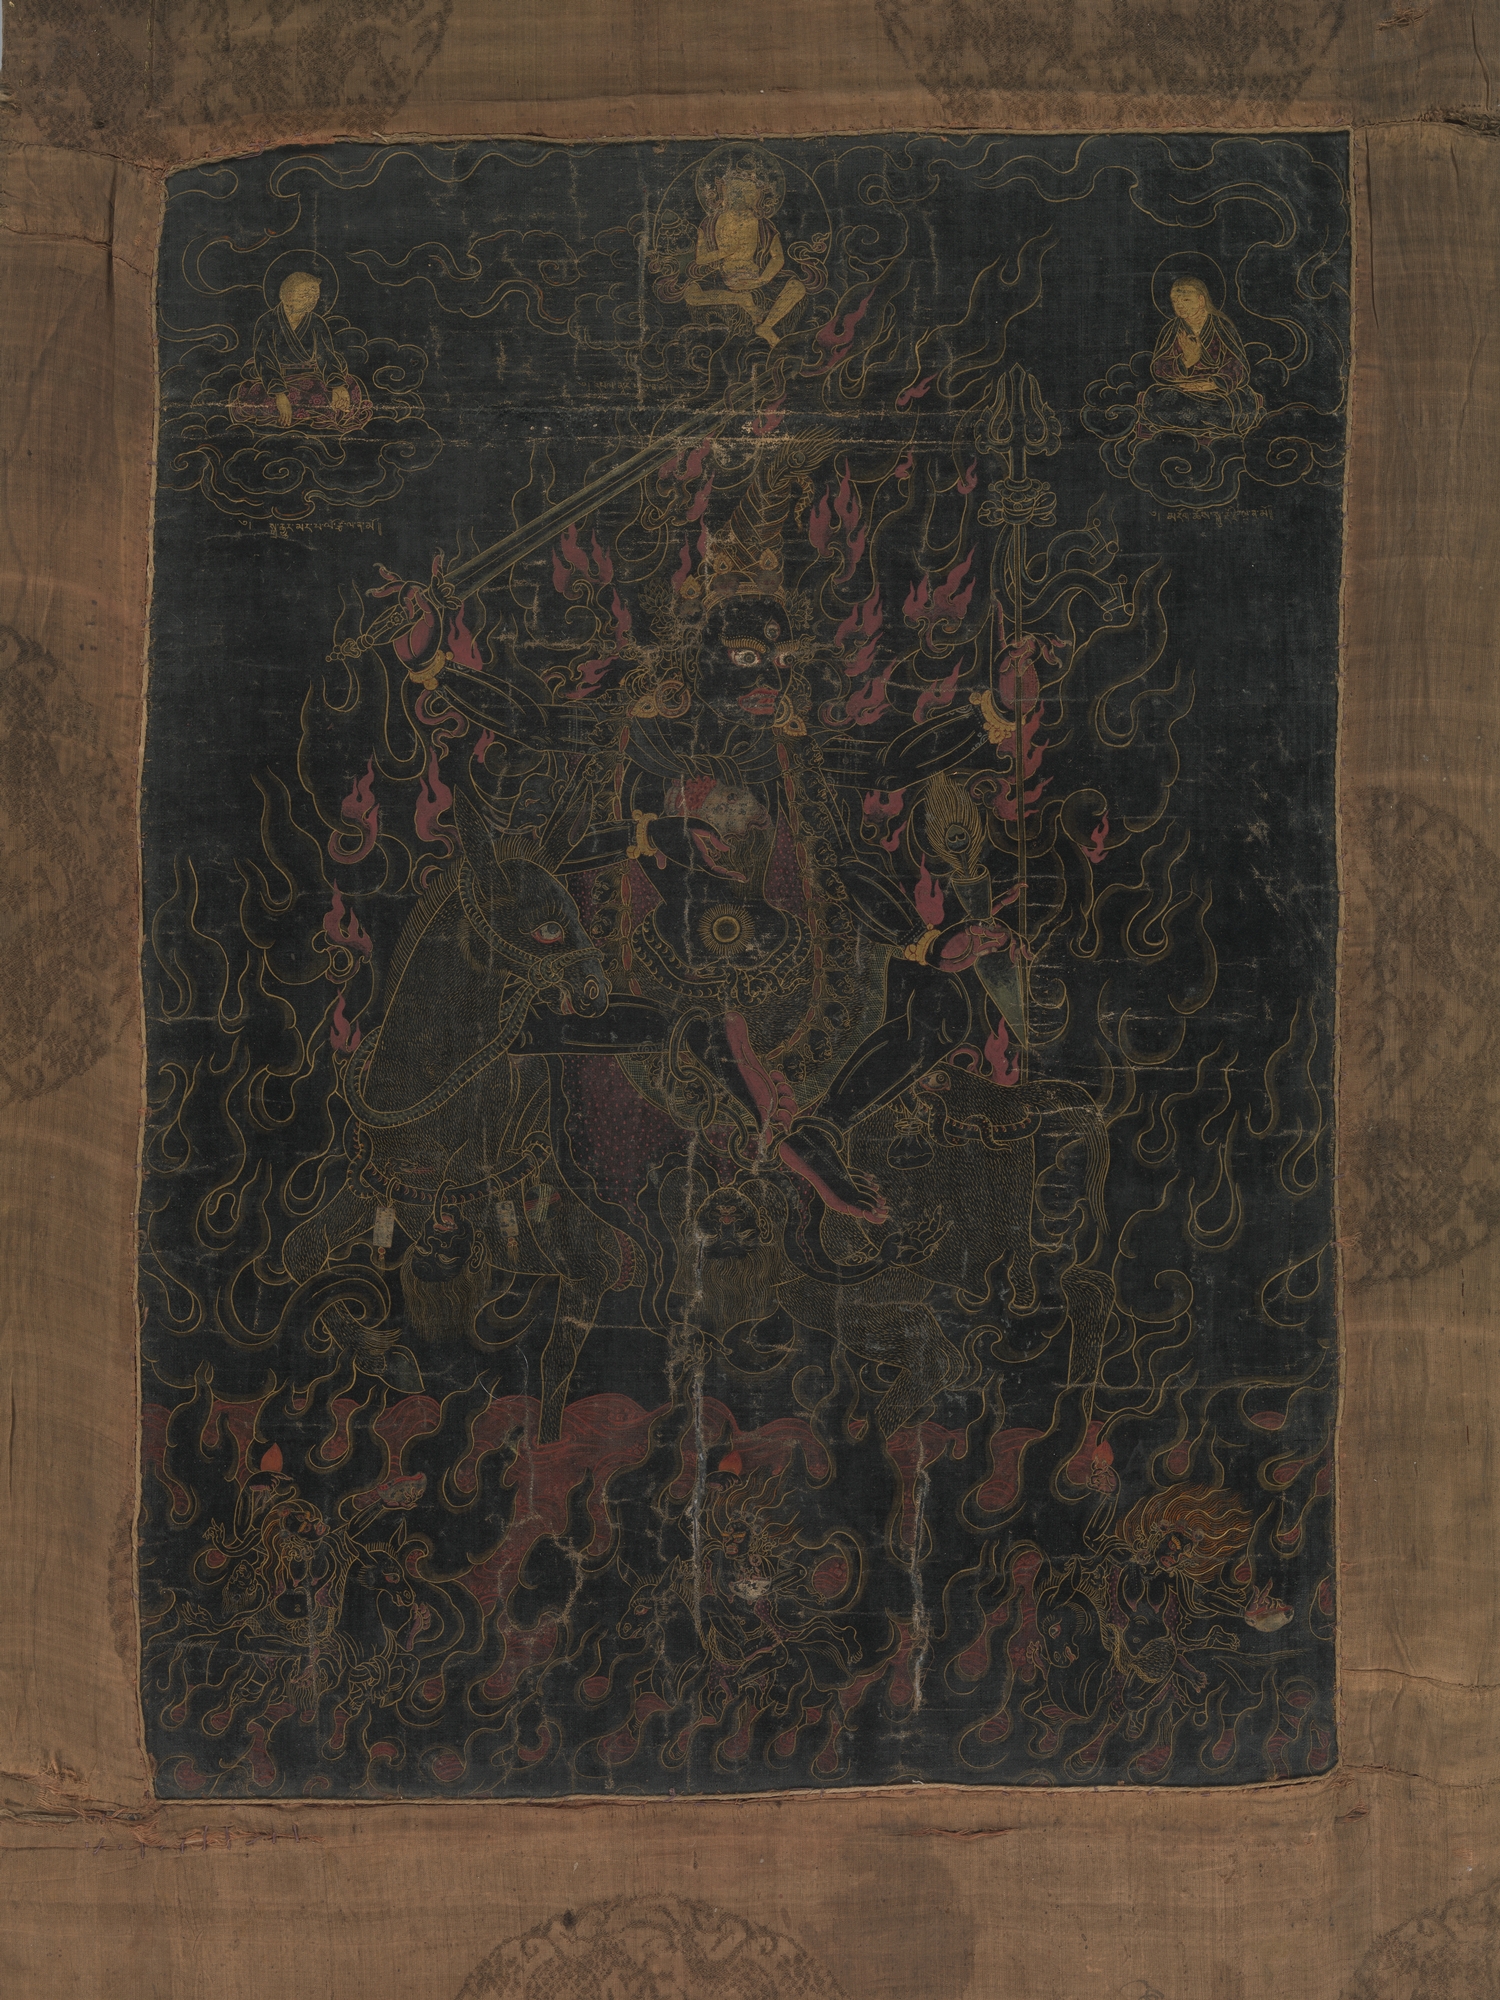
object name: painting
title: Lha Mo Riding on a Donkey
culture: tibetan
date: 1701-1800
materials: textile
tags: donkeys,deities